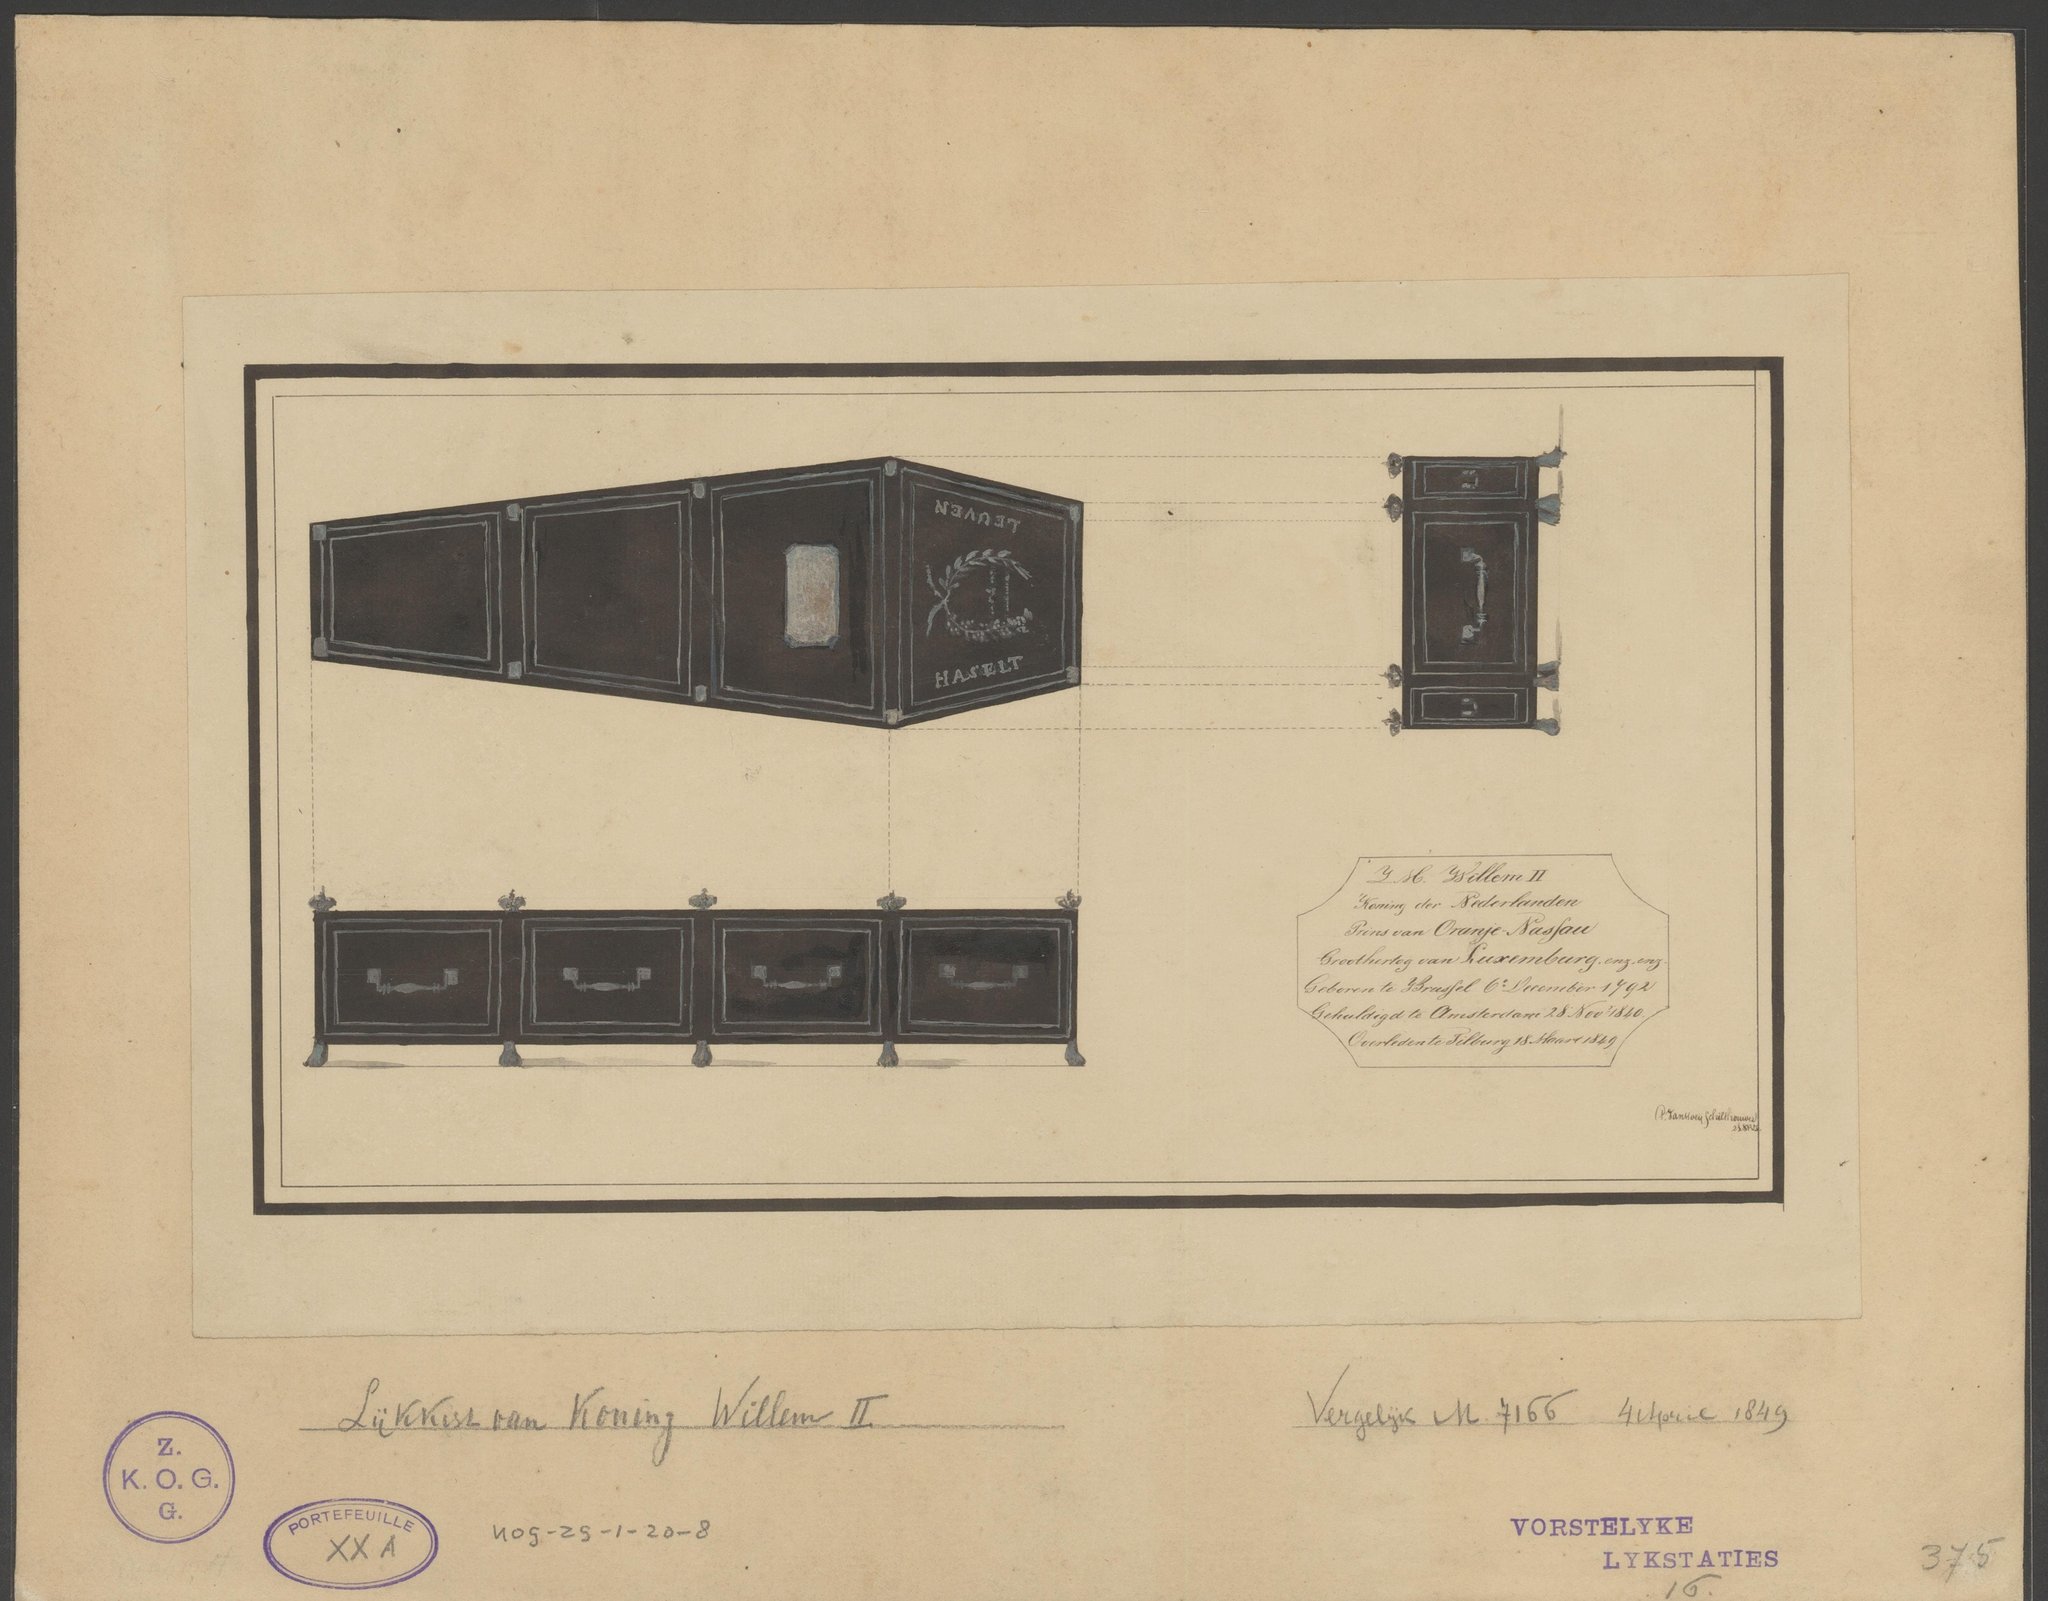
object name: drawing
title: Lijkkist van Willem III, koning der Nederlanden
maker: p. van moeij schiltbrouwer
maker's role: draughtsman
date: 1849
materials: gouache, ink, paper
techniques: brush, pen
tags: brussels, willem iii (koning der nederlanden), coffin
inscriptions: stamp, stamp, collector's mark: Lugt 1641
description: Onderwerpsrubrieken binnen de Atlas Zeden en Gewoonten: Zeden en Gewoonten in Engeren Zin, Des menschen beging, midden en einde, Vorstelijke lijkstaties.